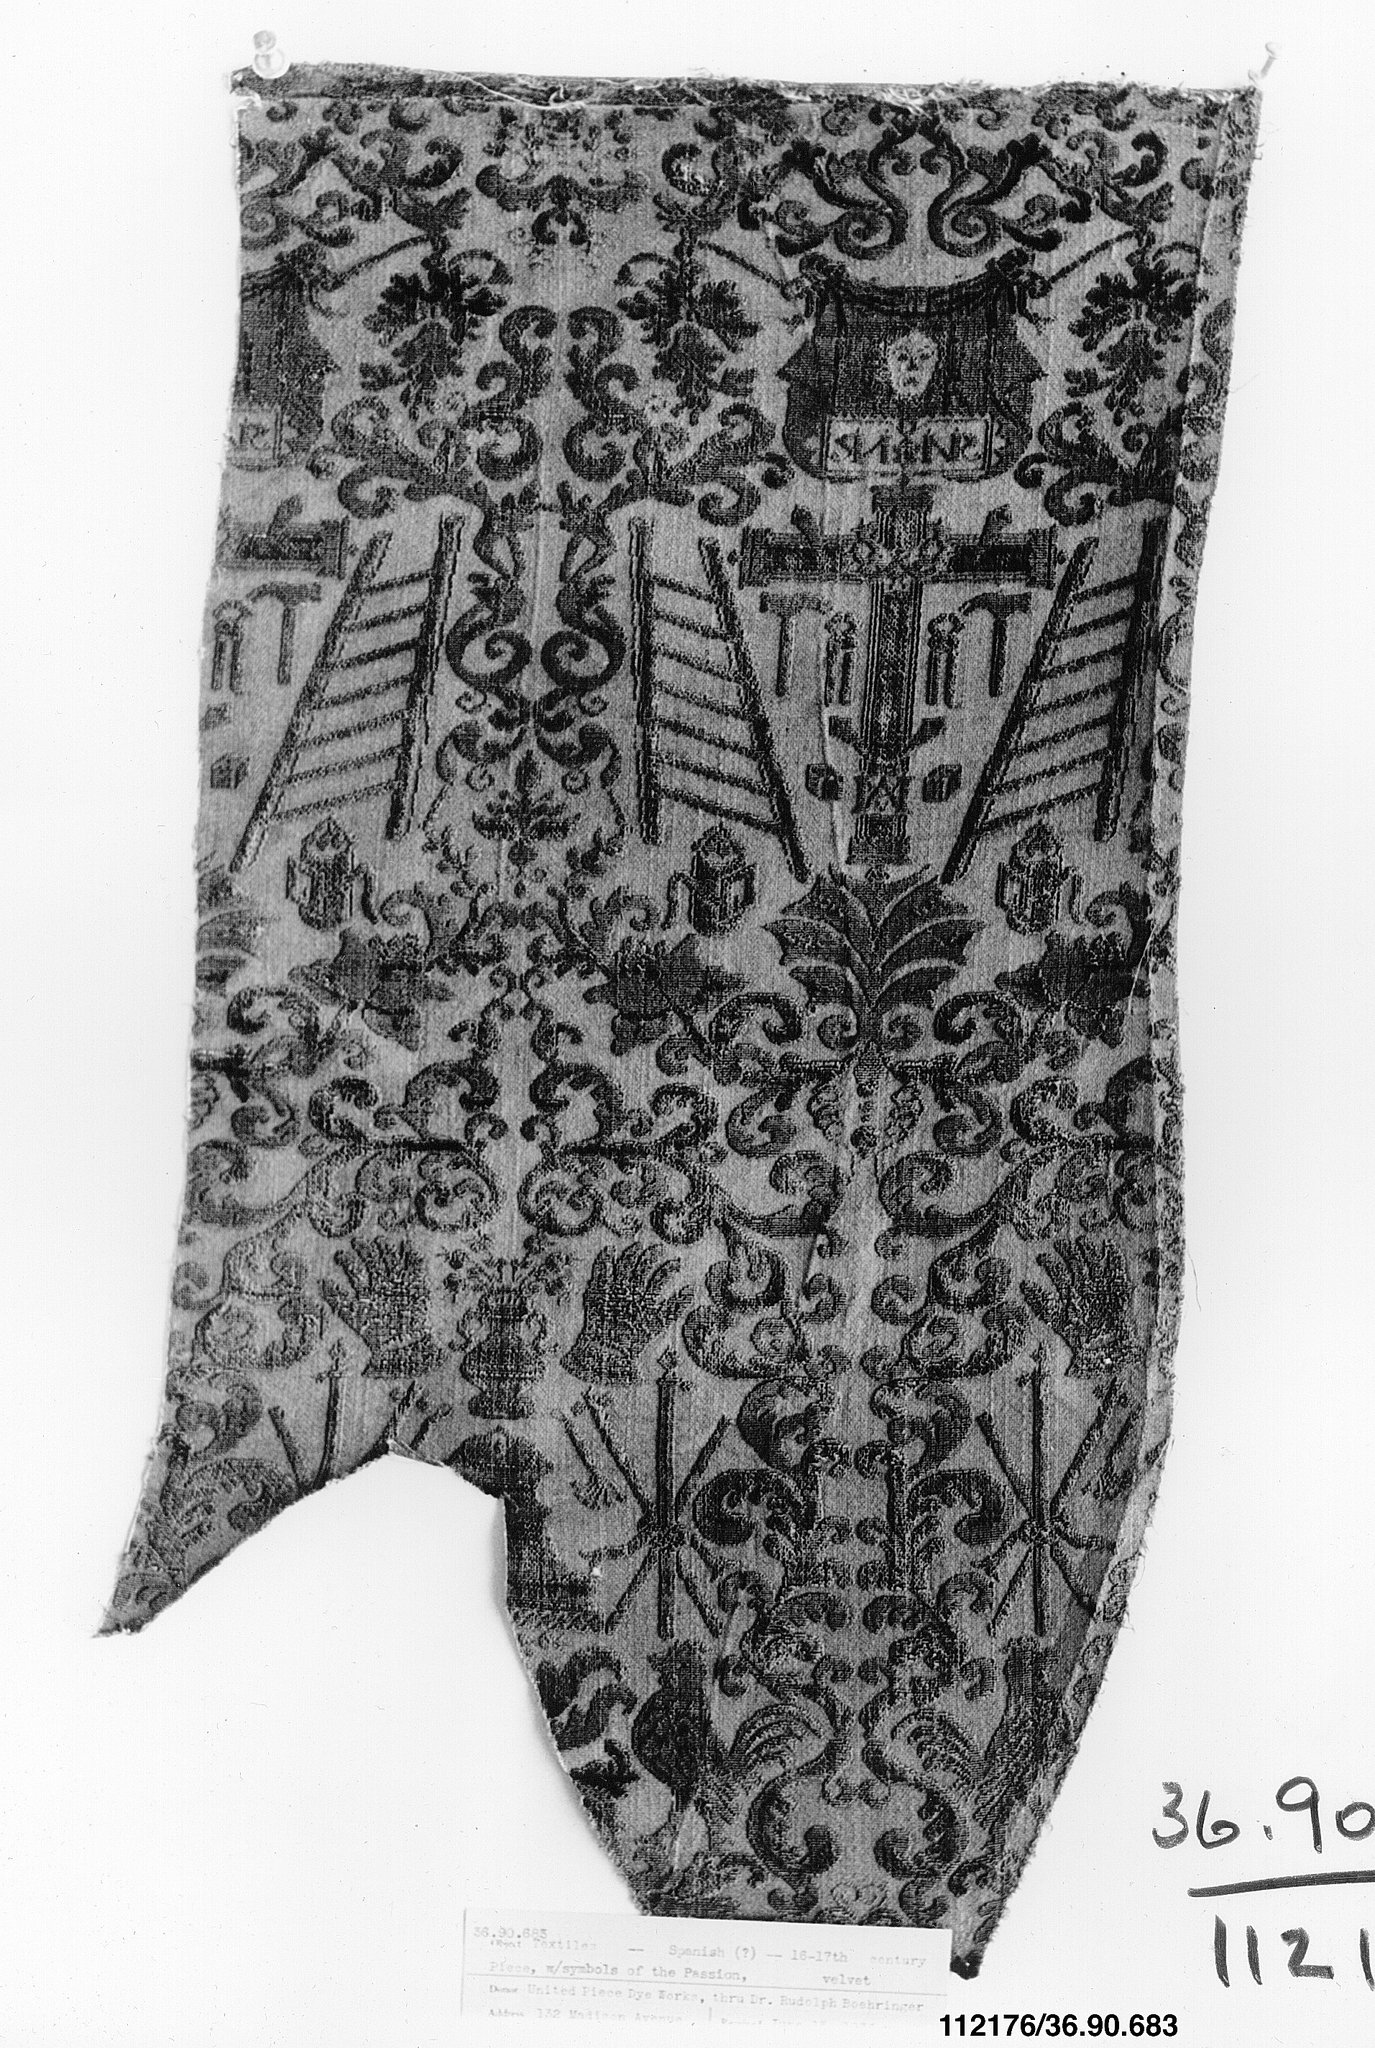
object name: fragment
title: Fragment of velvet with Instruments of the Passion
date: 1501-1700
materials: silk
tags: cross,ladders